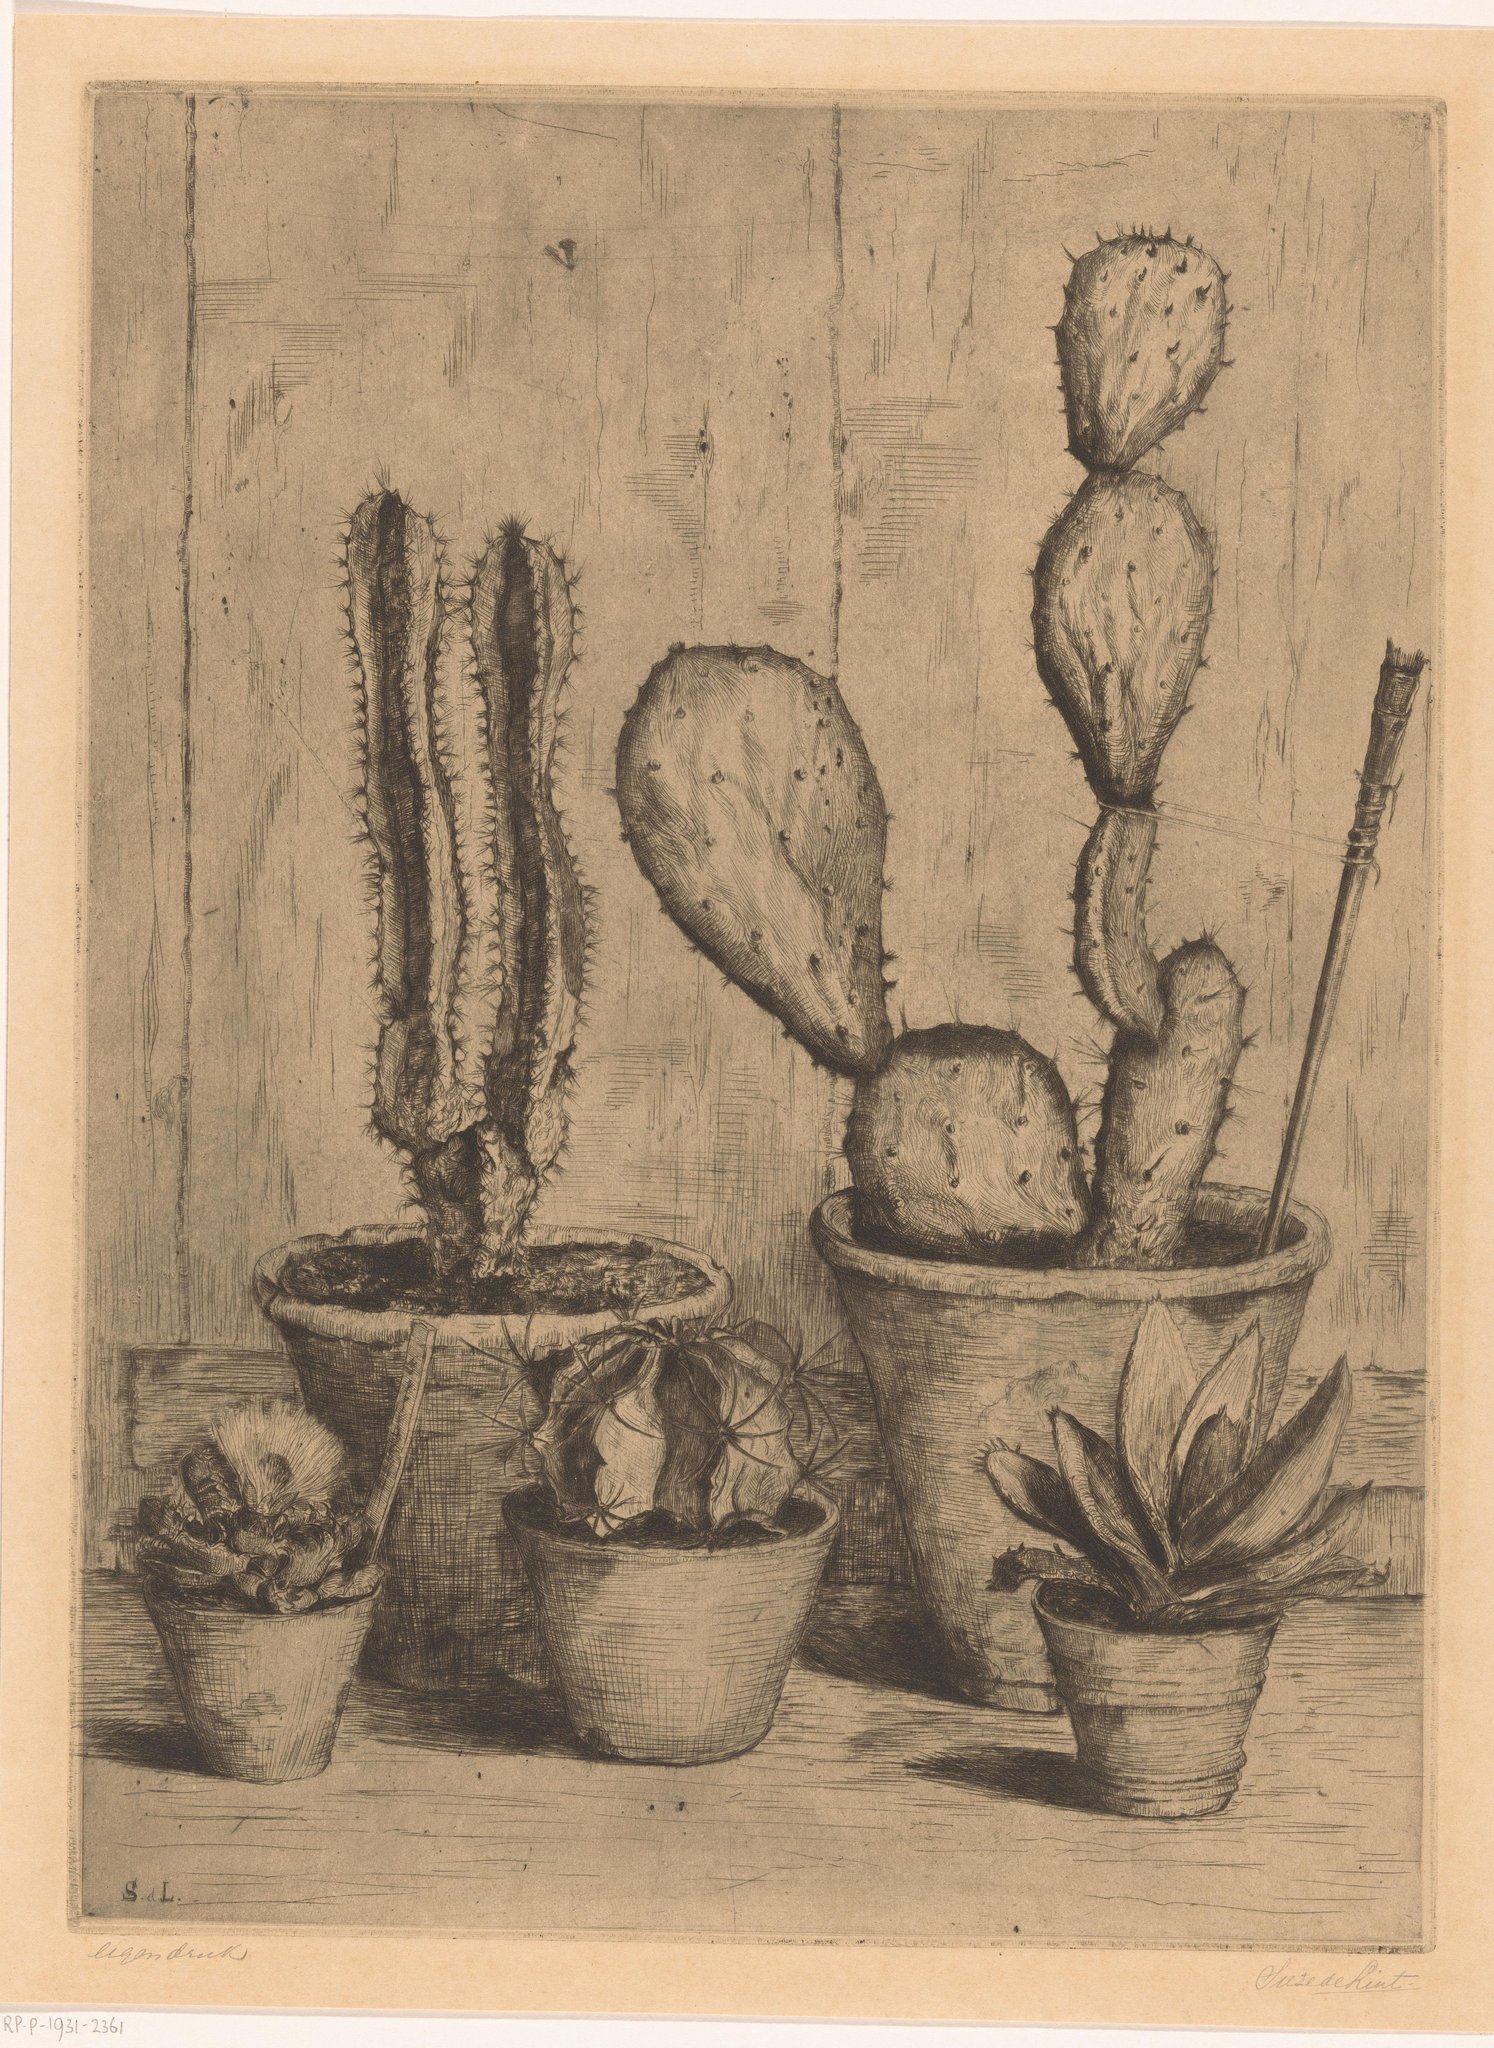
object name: print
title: Cactussen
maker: suze de lint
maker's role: print maker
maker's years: 1878-1953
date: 1888-1931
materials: paper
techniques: etching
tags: plants and herbs: cactus, potted plants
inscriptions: collector's mark: Lugt 2228